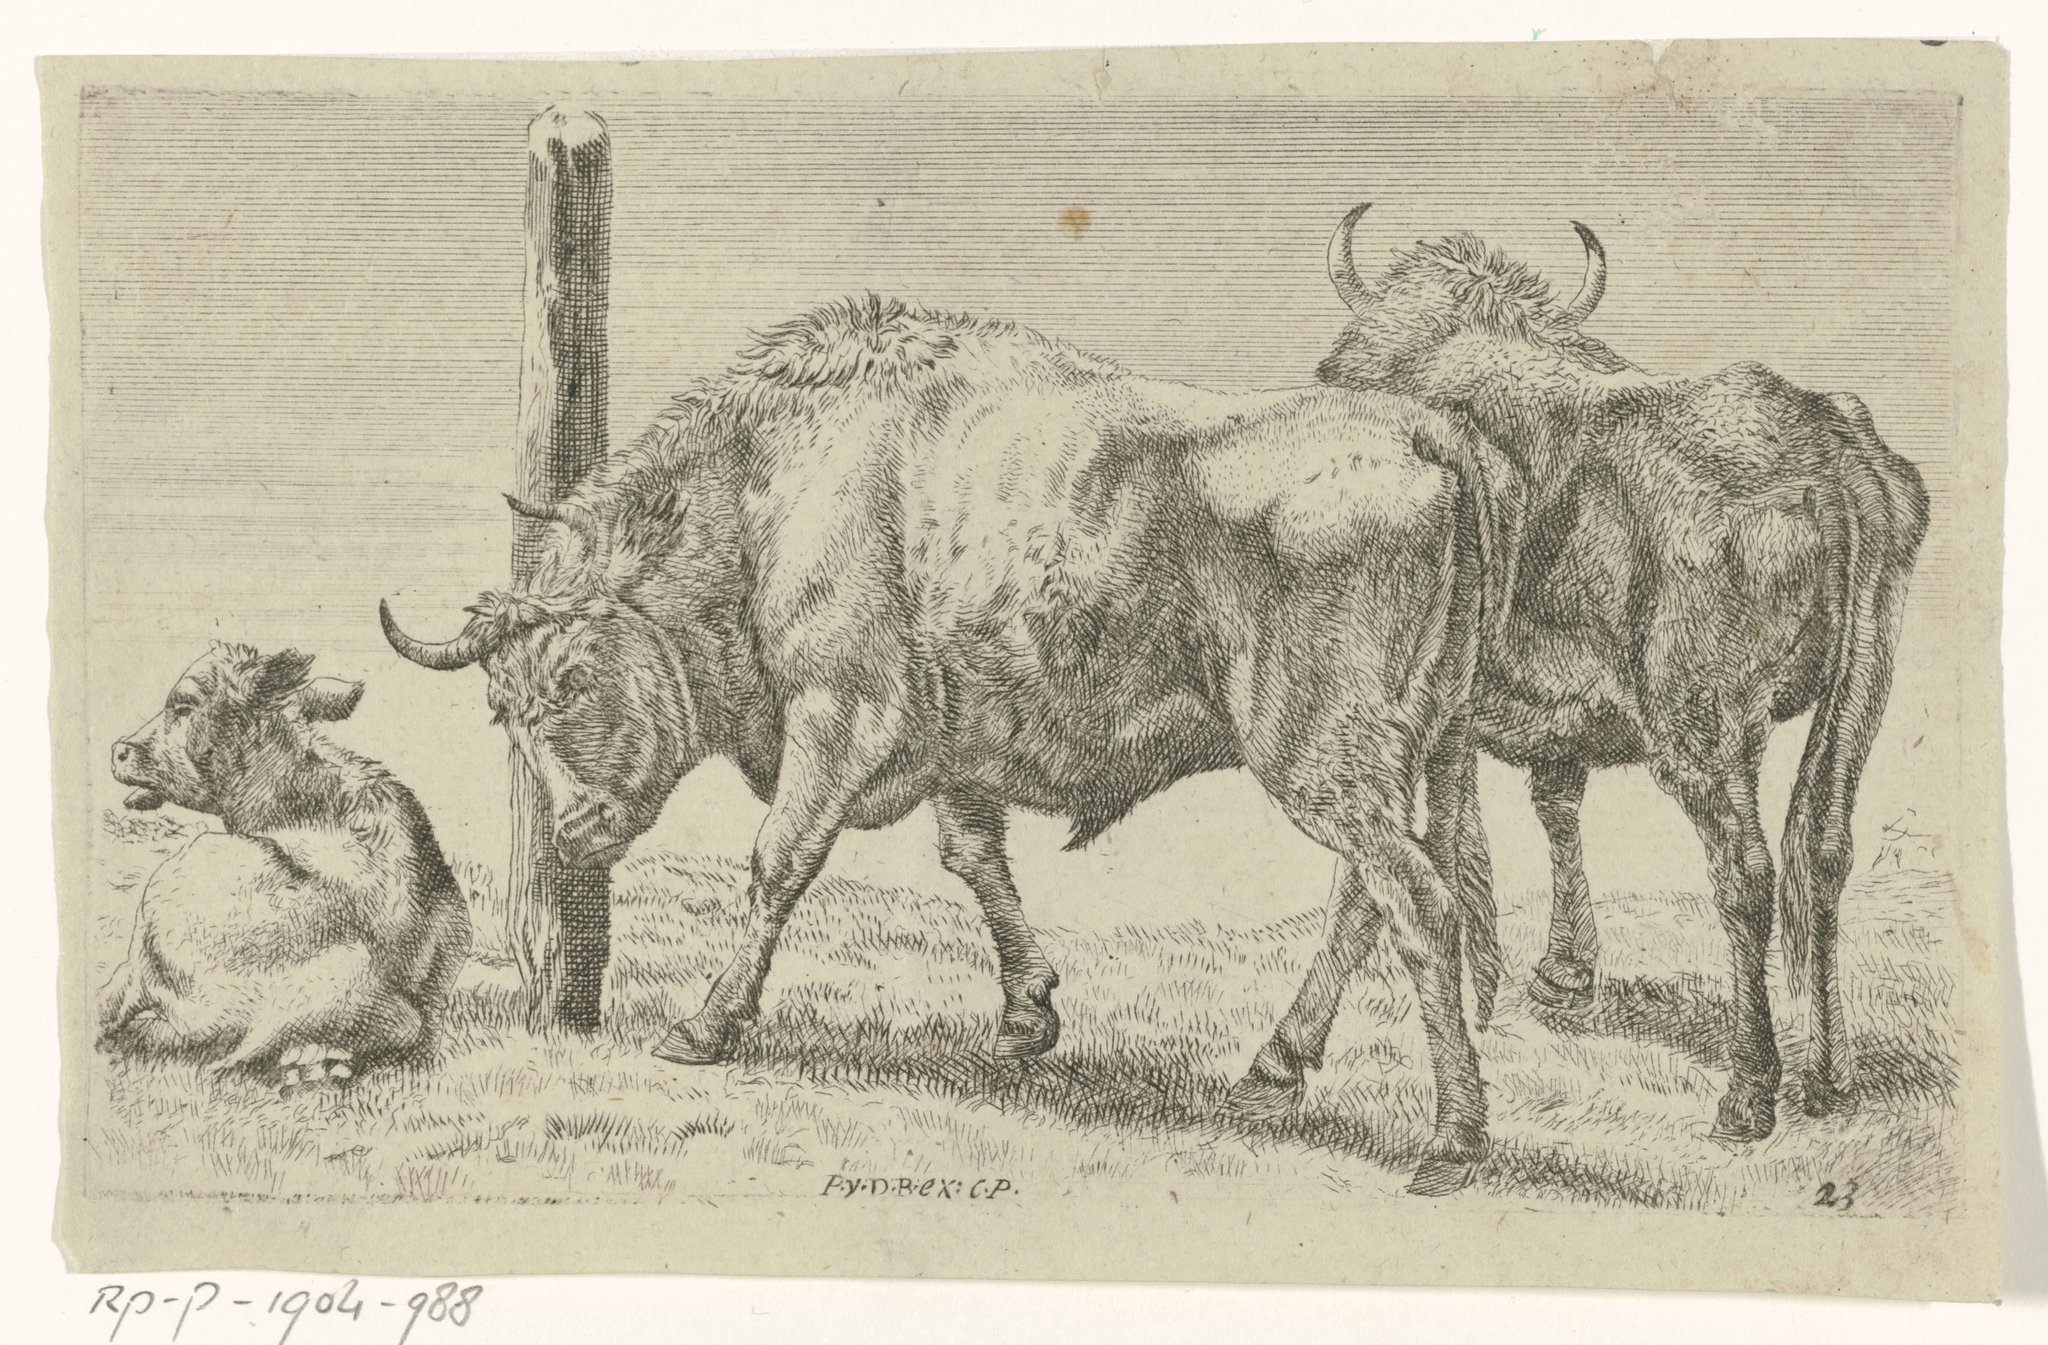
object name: print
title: Stieren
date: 1694-1737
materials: paper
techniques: engraving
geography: amsterdam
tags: cow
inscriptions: collector's mark: Lugt 2228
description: In een weiland staan twee stieren, waarvan een zich tegen een paal wrijft. Links een liggende koe.